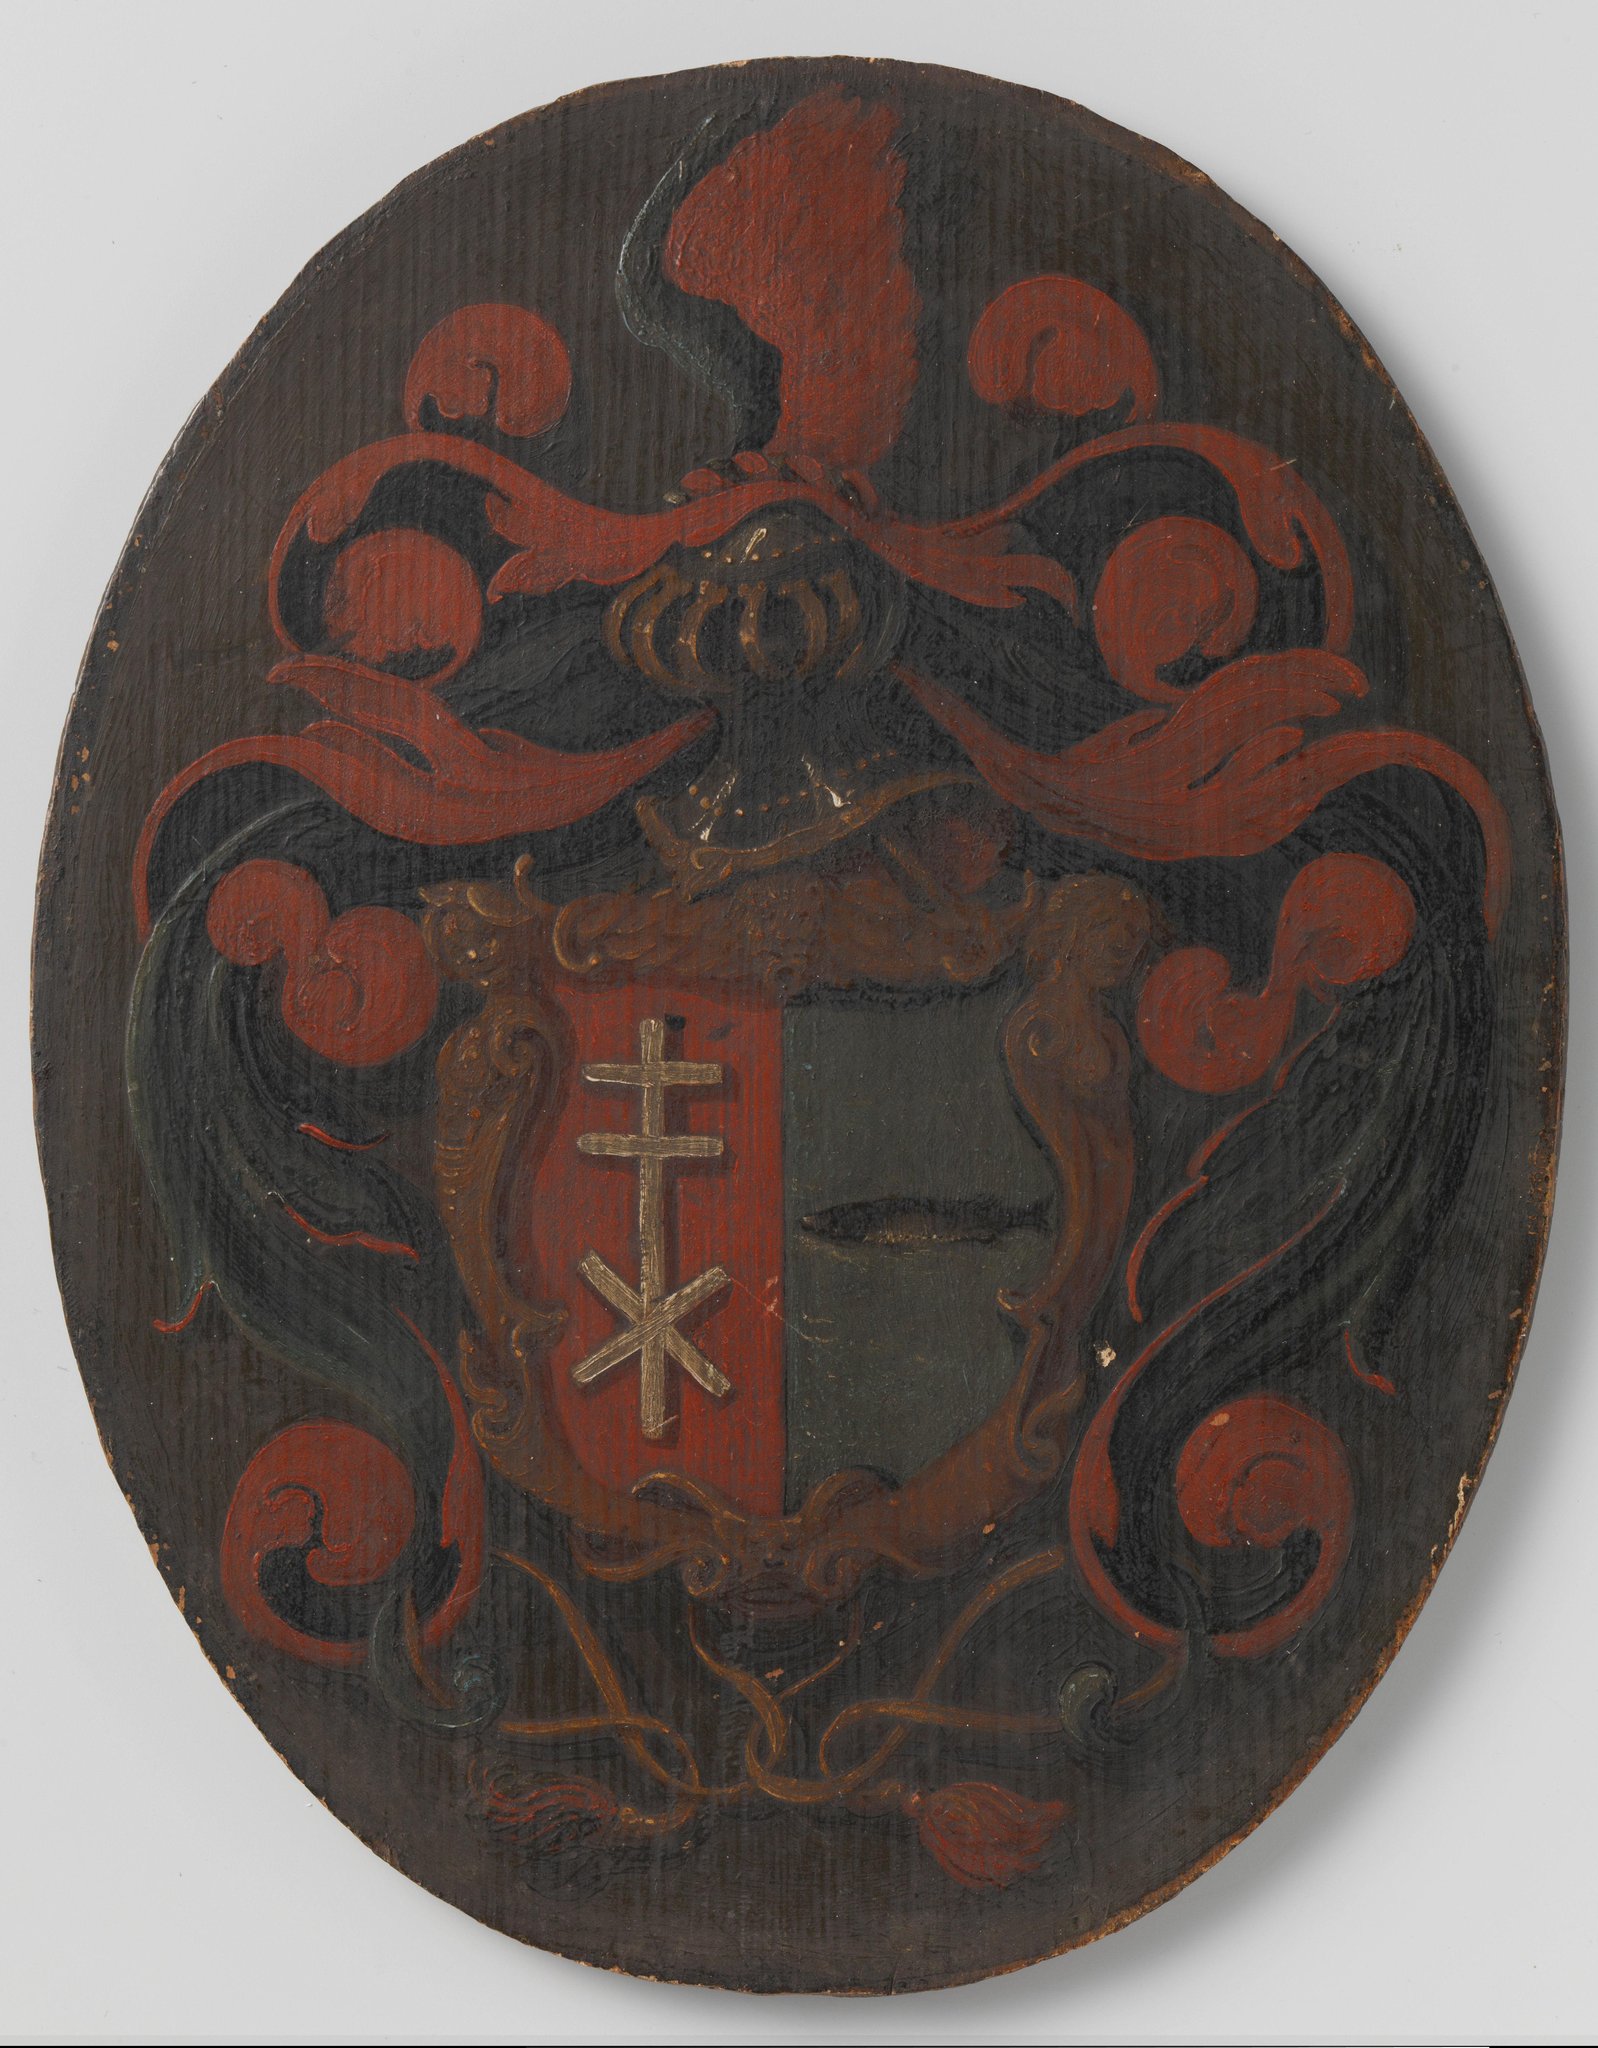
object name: wapenbord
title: Wapenbord met het wapen van de familie Snoeck (Amsterdam)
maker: Anonymous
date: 1700-1799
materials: oil, panel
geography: northern netherlands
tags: armorial bearing, heraldry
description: Wapenbord met het wapen van de familie Snoeck (Amsterdam). Met helm en dekkleed. Onderdeel van de collectie heraldische objecten.